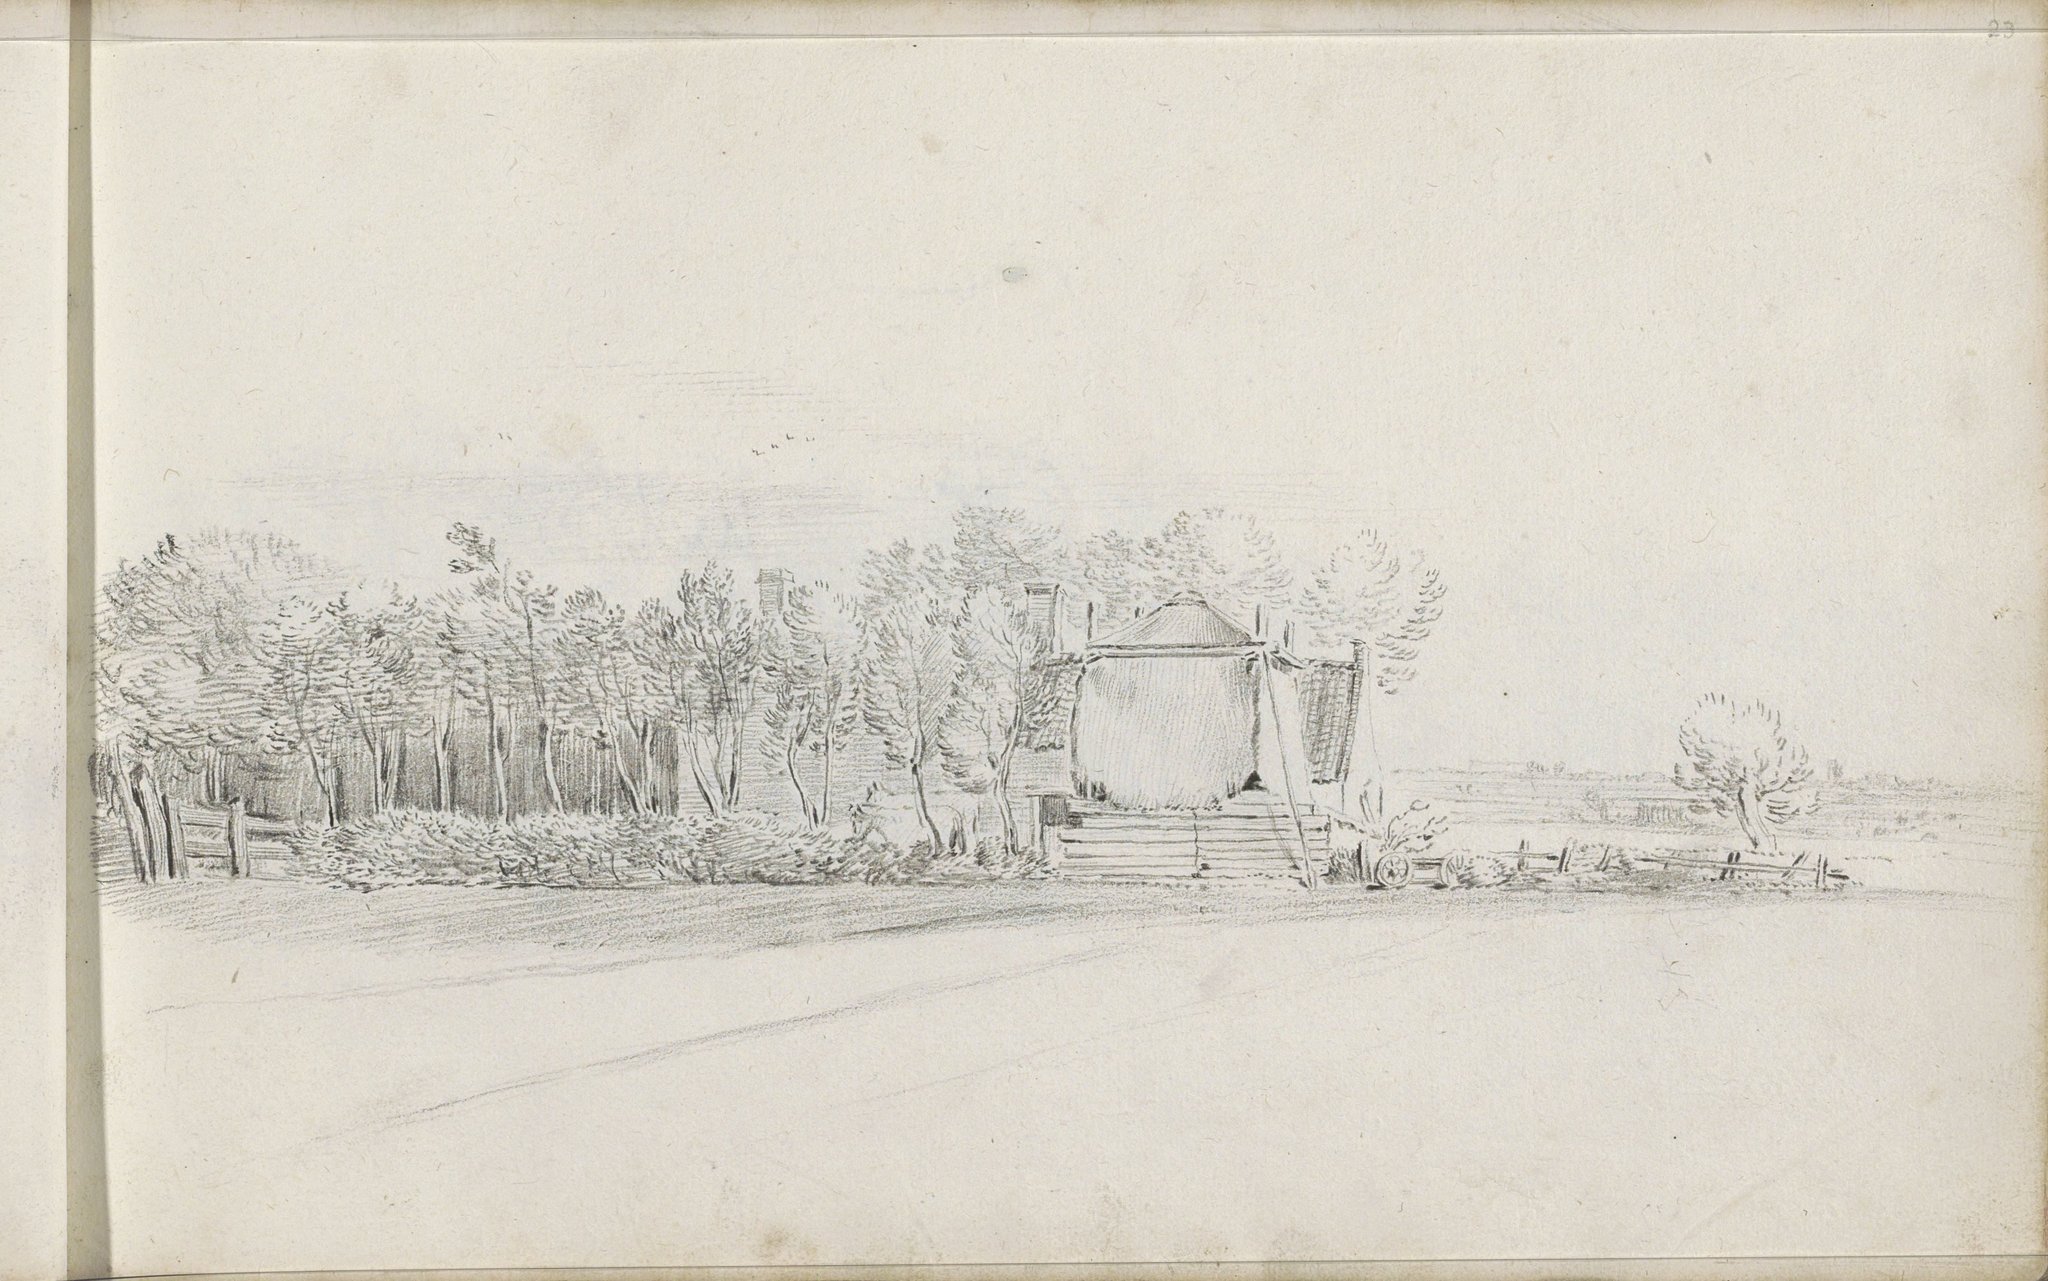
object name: sketchbook leaf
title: Landschap met een hooimijt bij een boerderij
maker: pieter moninckx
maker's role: draughtsman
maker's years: 1606-1686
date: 1645-1646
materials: chalk, paper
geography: the hague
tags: hay-stack, farm or solitary house in landscape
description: Blad 23 recto uit een schetsboek met 39 bladen.